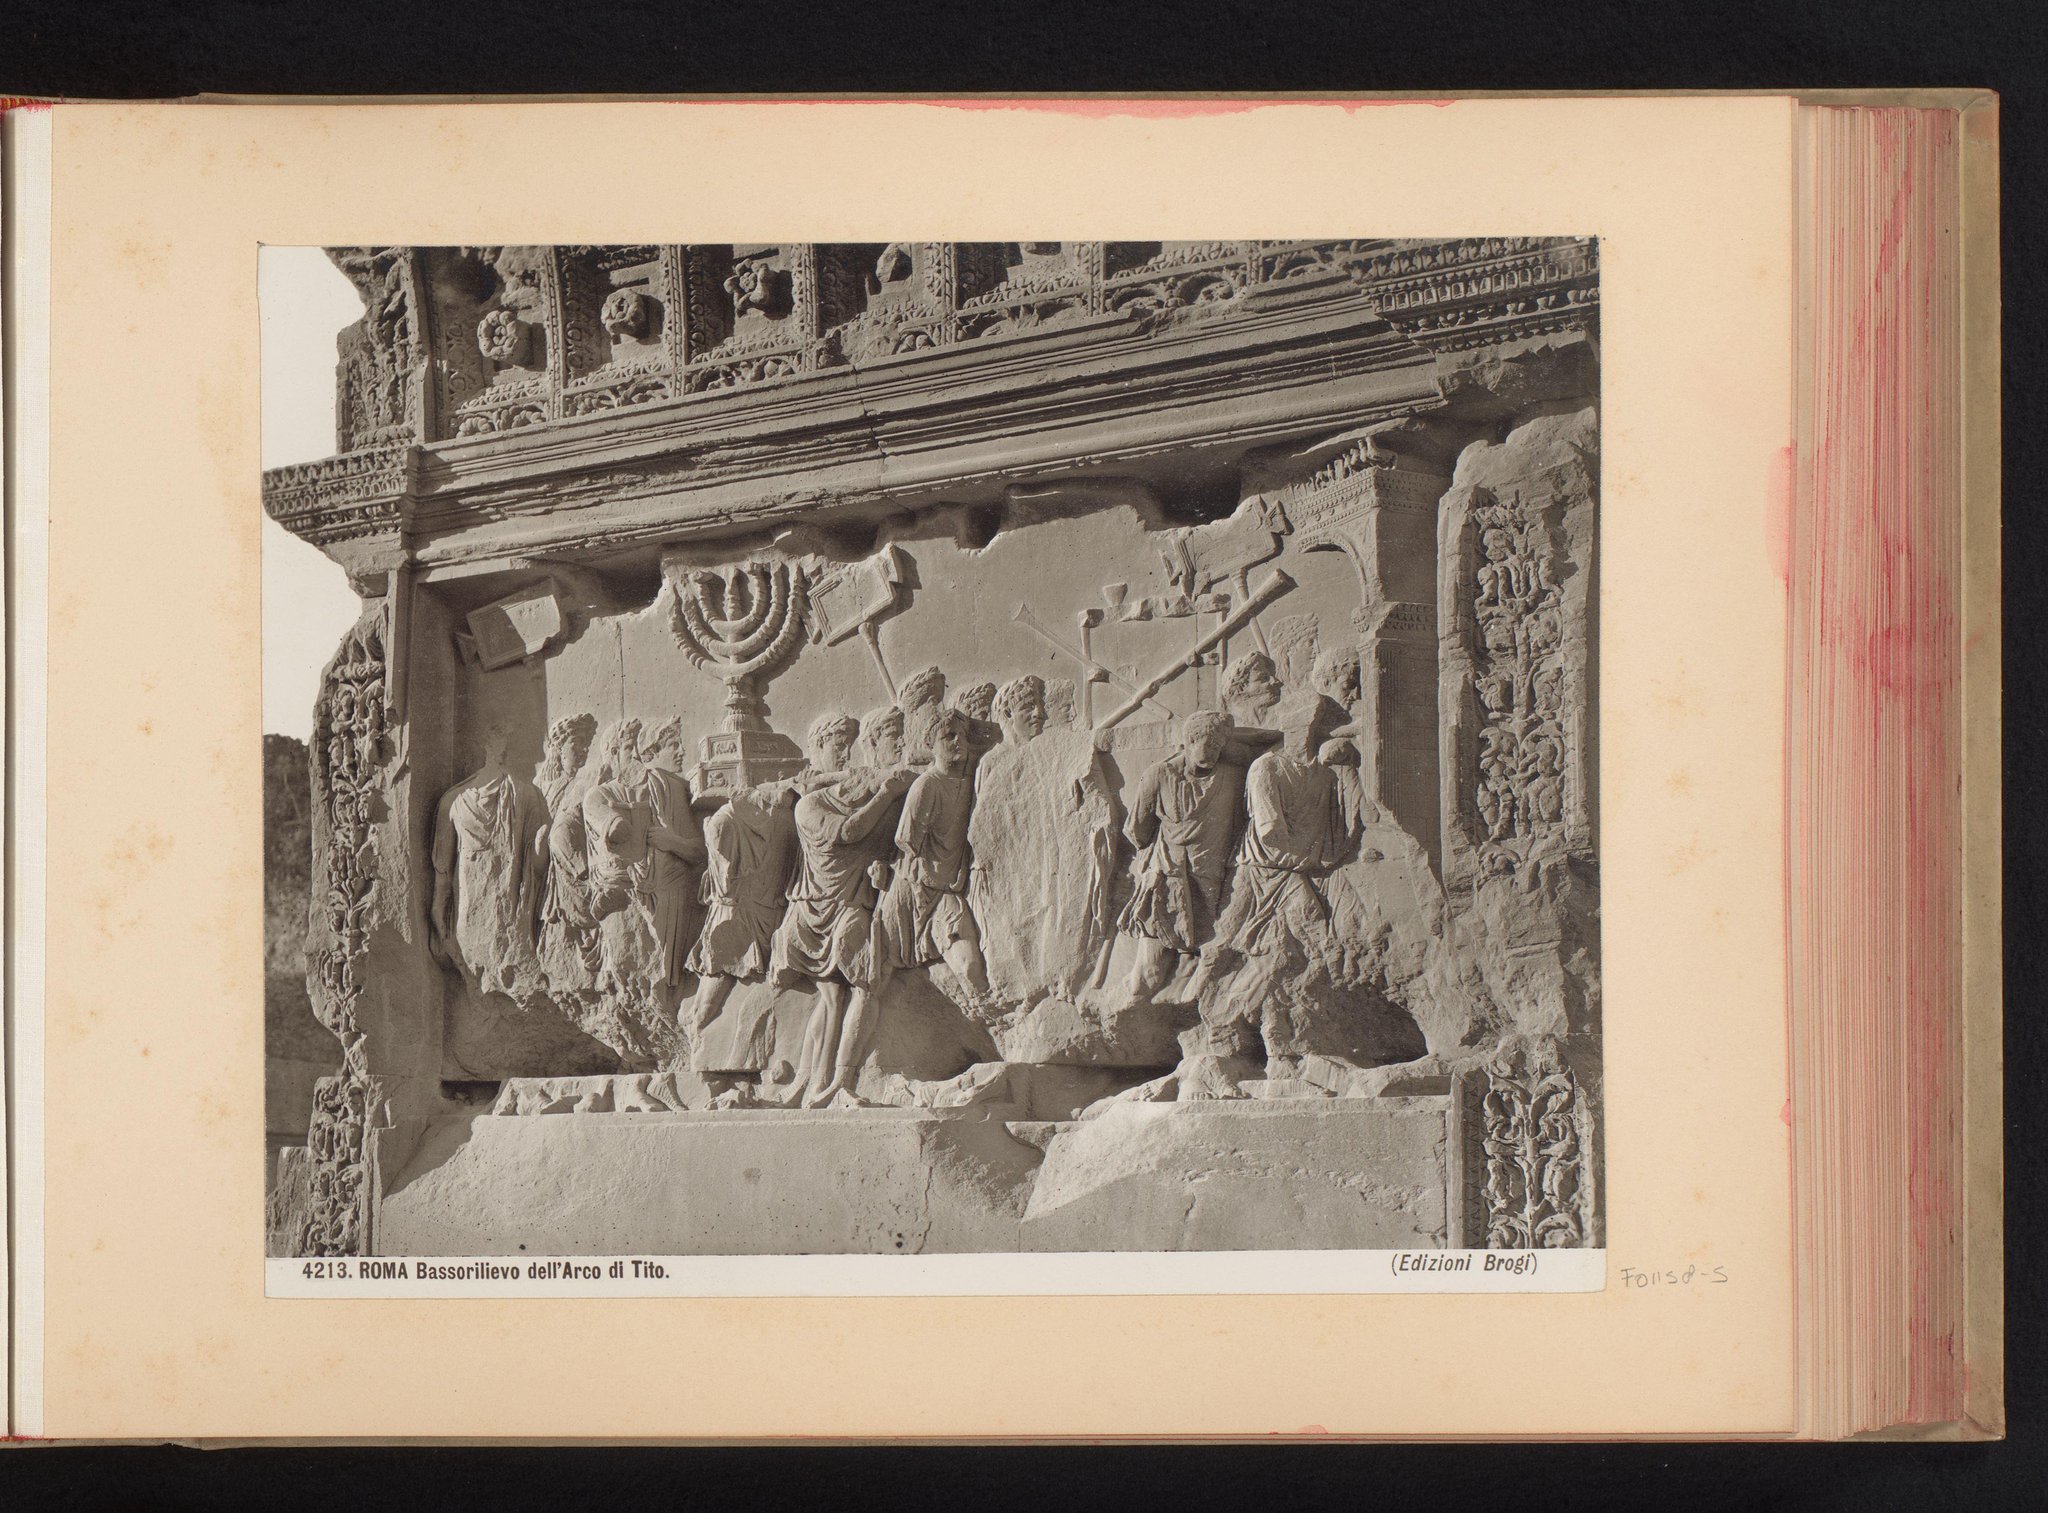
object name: photograph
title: Bas-reliëf op de Boog van Titus te Rome, voorstellende voorwerpen die uit de Tempel van Jeruzalem als krijgsbuit worden meegenomen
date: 1875-1907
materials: photographic support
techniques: gelatin silver print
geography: rome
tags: booty, spoil, emperor titus destroying the temple of jerusalem, sculpture (+ relief ~ sculpture)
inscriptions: number: ‘4213’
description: Onderdeel van Fotoalbum met opnames van bezienswaardigheden en kunstwerken in Italië.